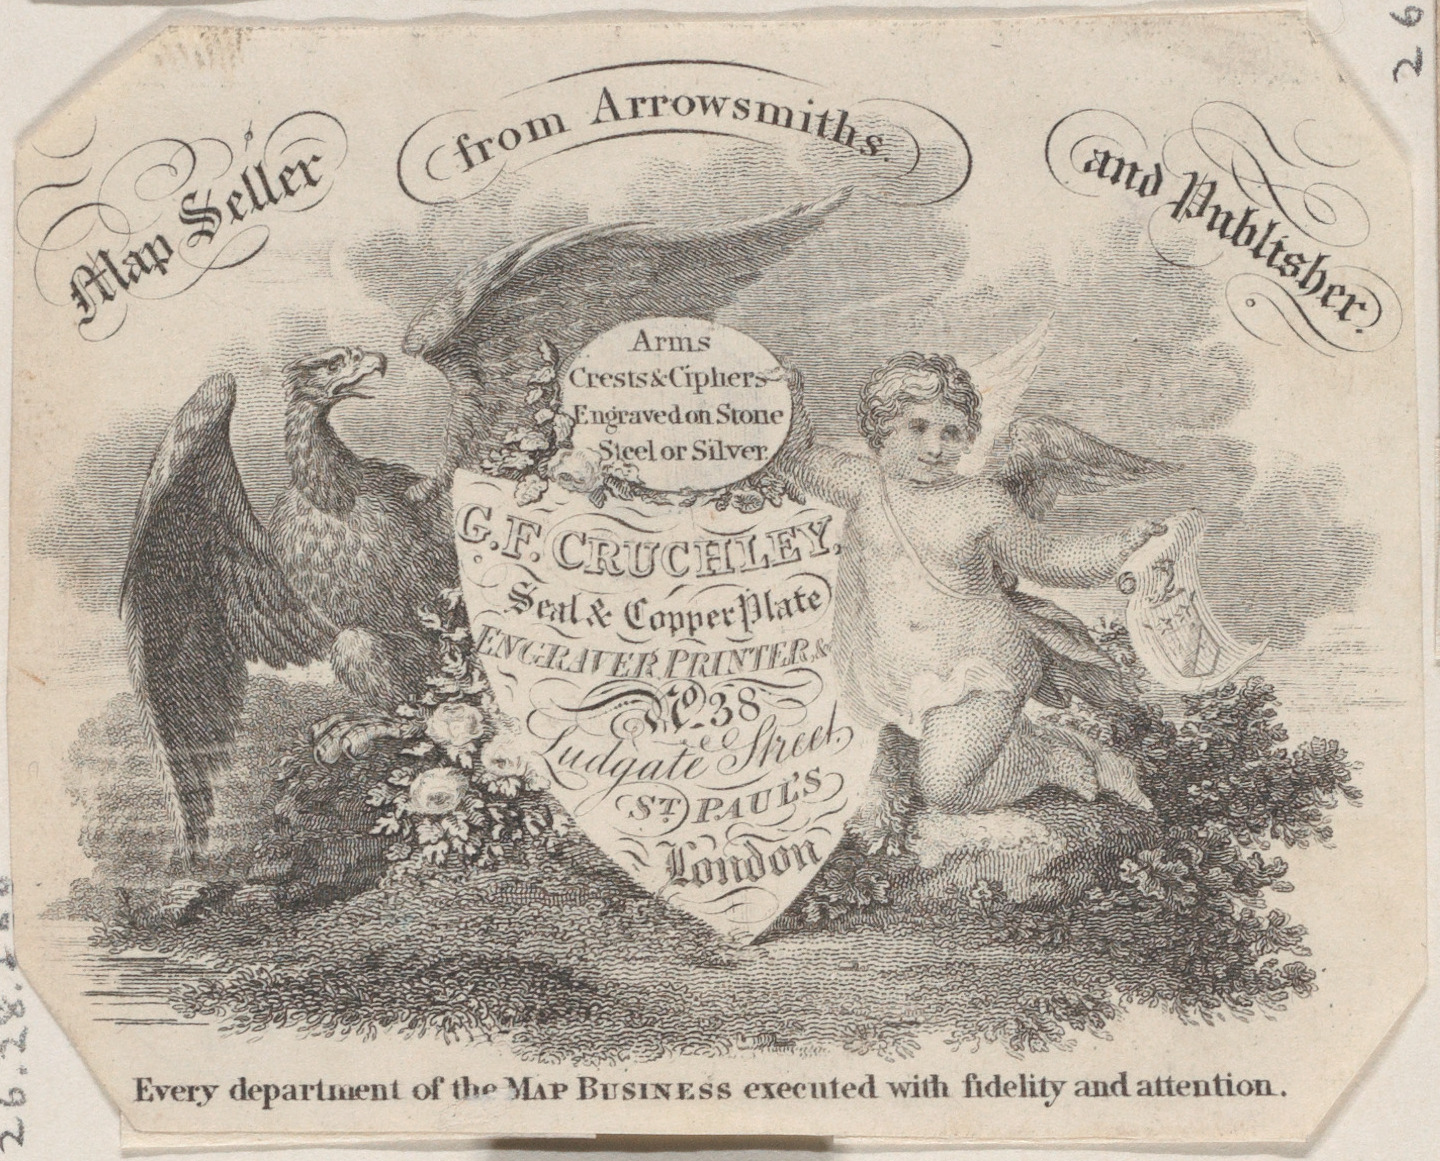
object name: print, trade card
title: Trade Card for G.F. Cruchley, Map Seller and Publisher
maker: anonymous, british, 19th century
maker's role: artist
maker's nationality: british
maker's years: 1800-1900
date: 1801-1900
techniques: engraving